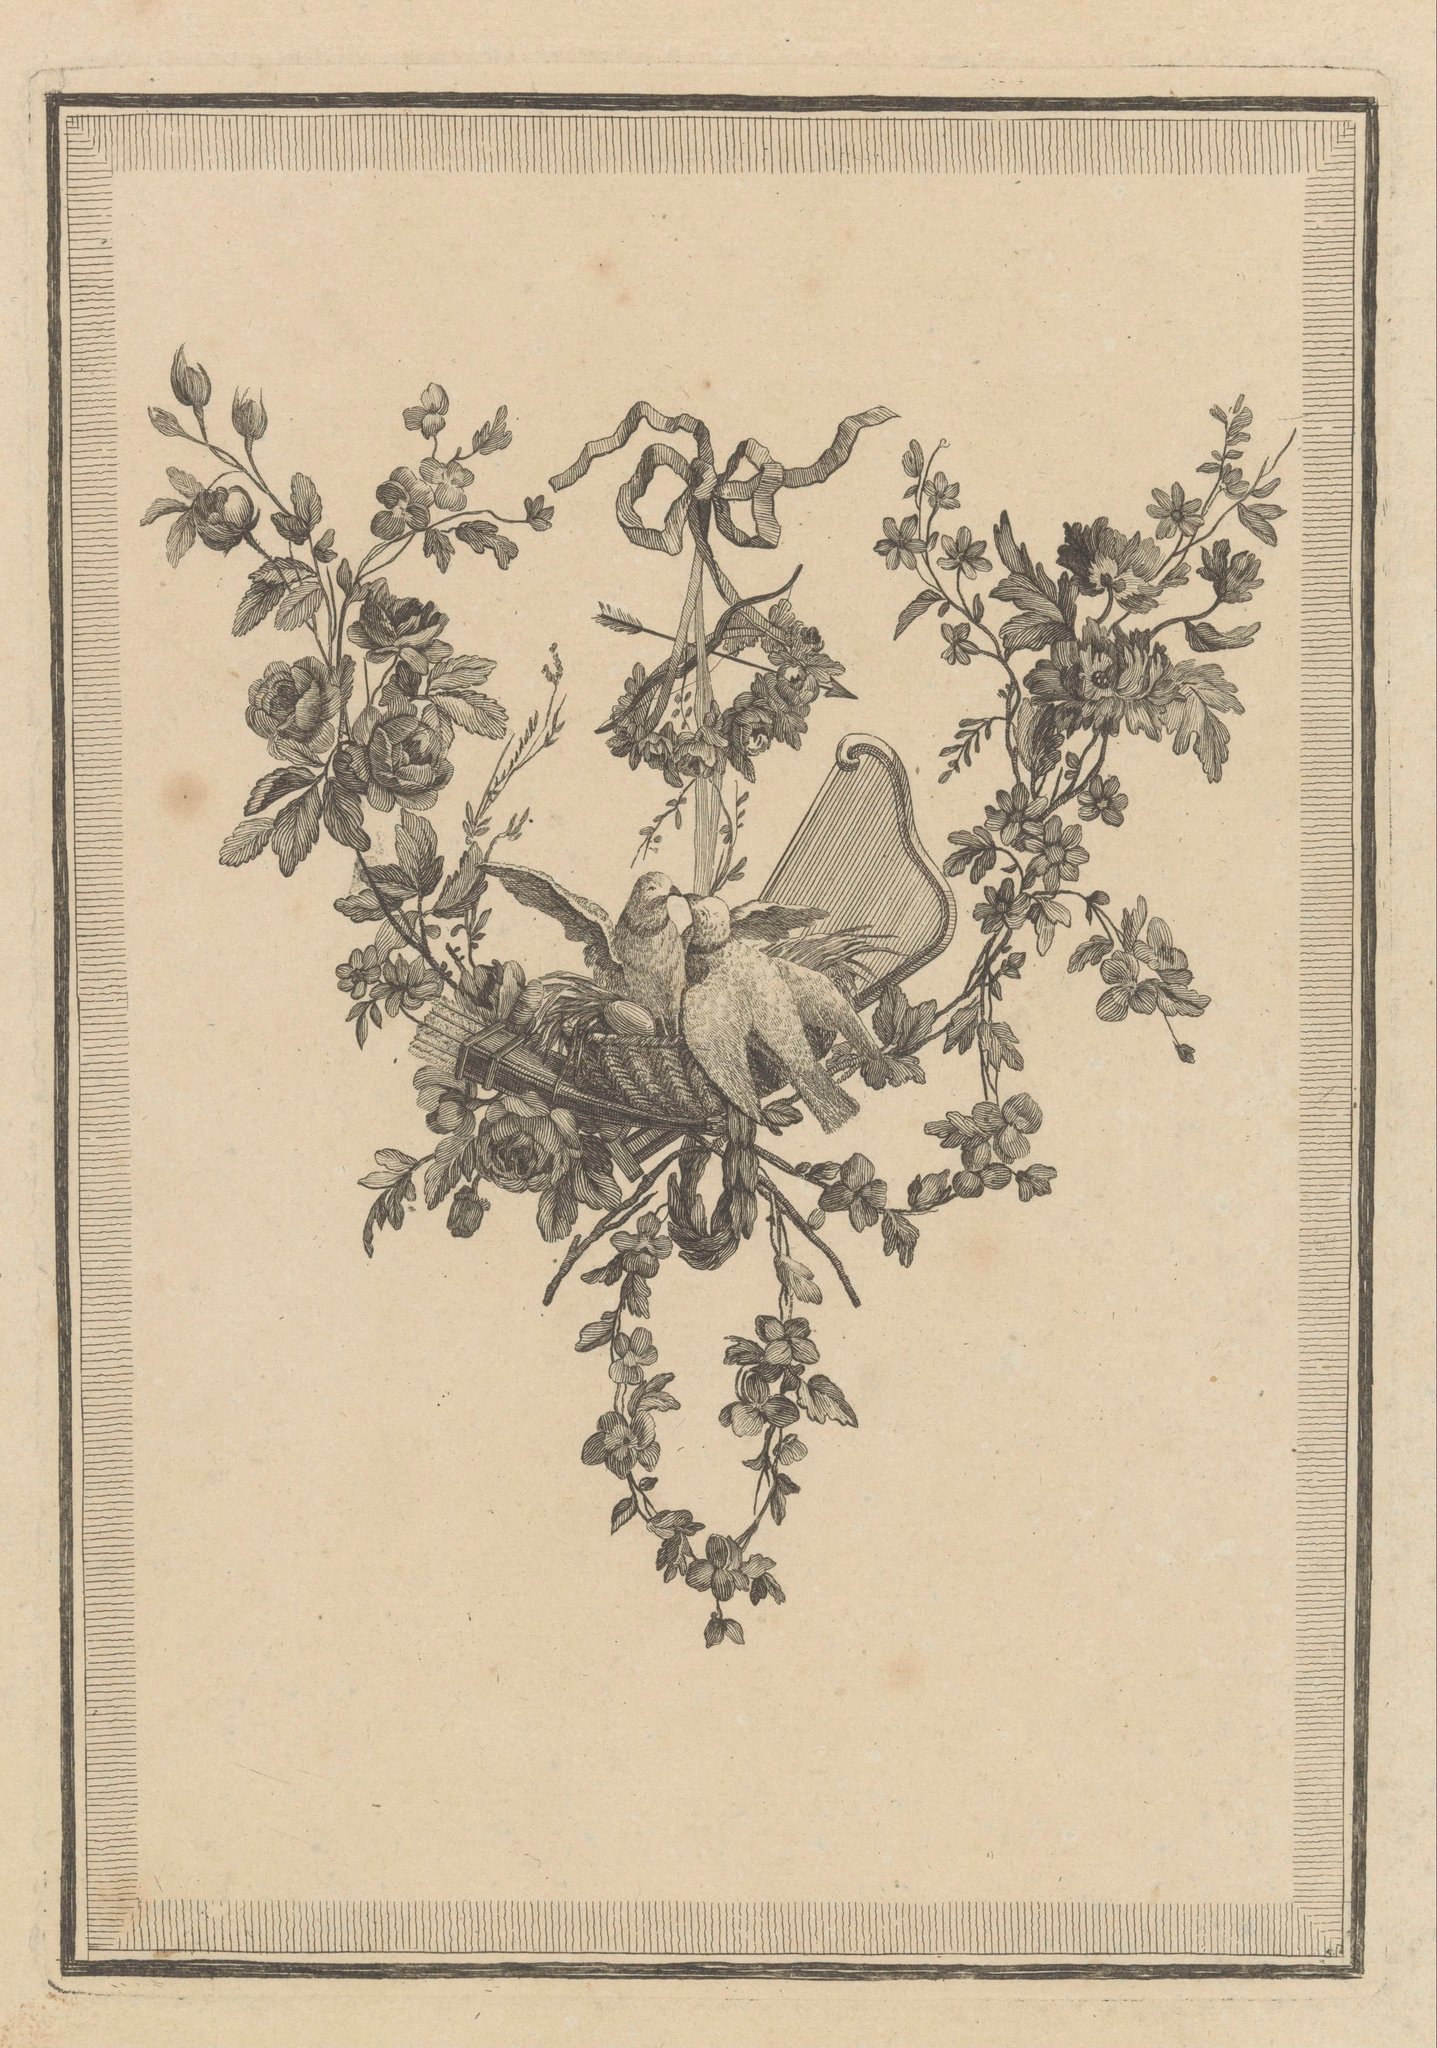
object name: ornament print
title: Livre De Trophées des Arts et Scienses, Dans un Nouveau Gout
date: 1760-1784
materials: paper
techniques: etching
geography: paris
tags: trophy, i.e.: decorative arrangement of symbolic or typical objects ~ ornament, other birds: dove, harp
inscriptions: collector's mark: Lugt 2228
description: Een trofee met bloemen, een krans, pijl en boog, een harp, twee duiven in een mand en een pijlenkoker.